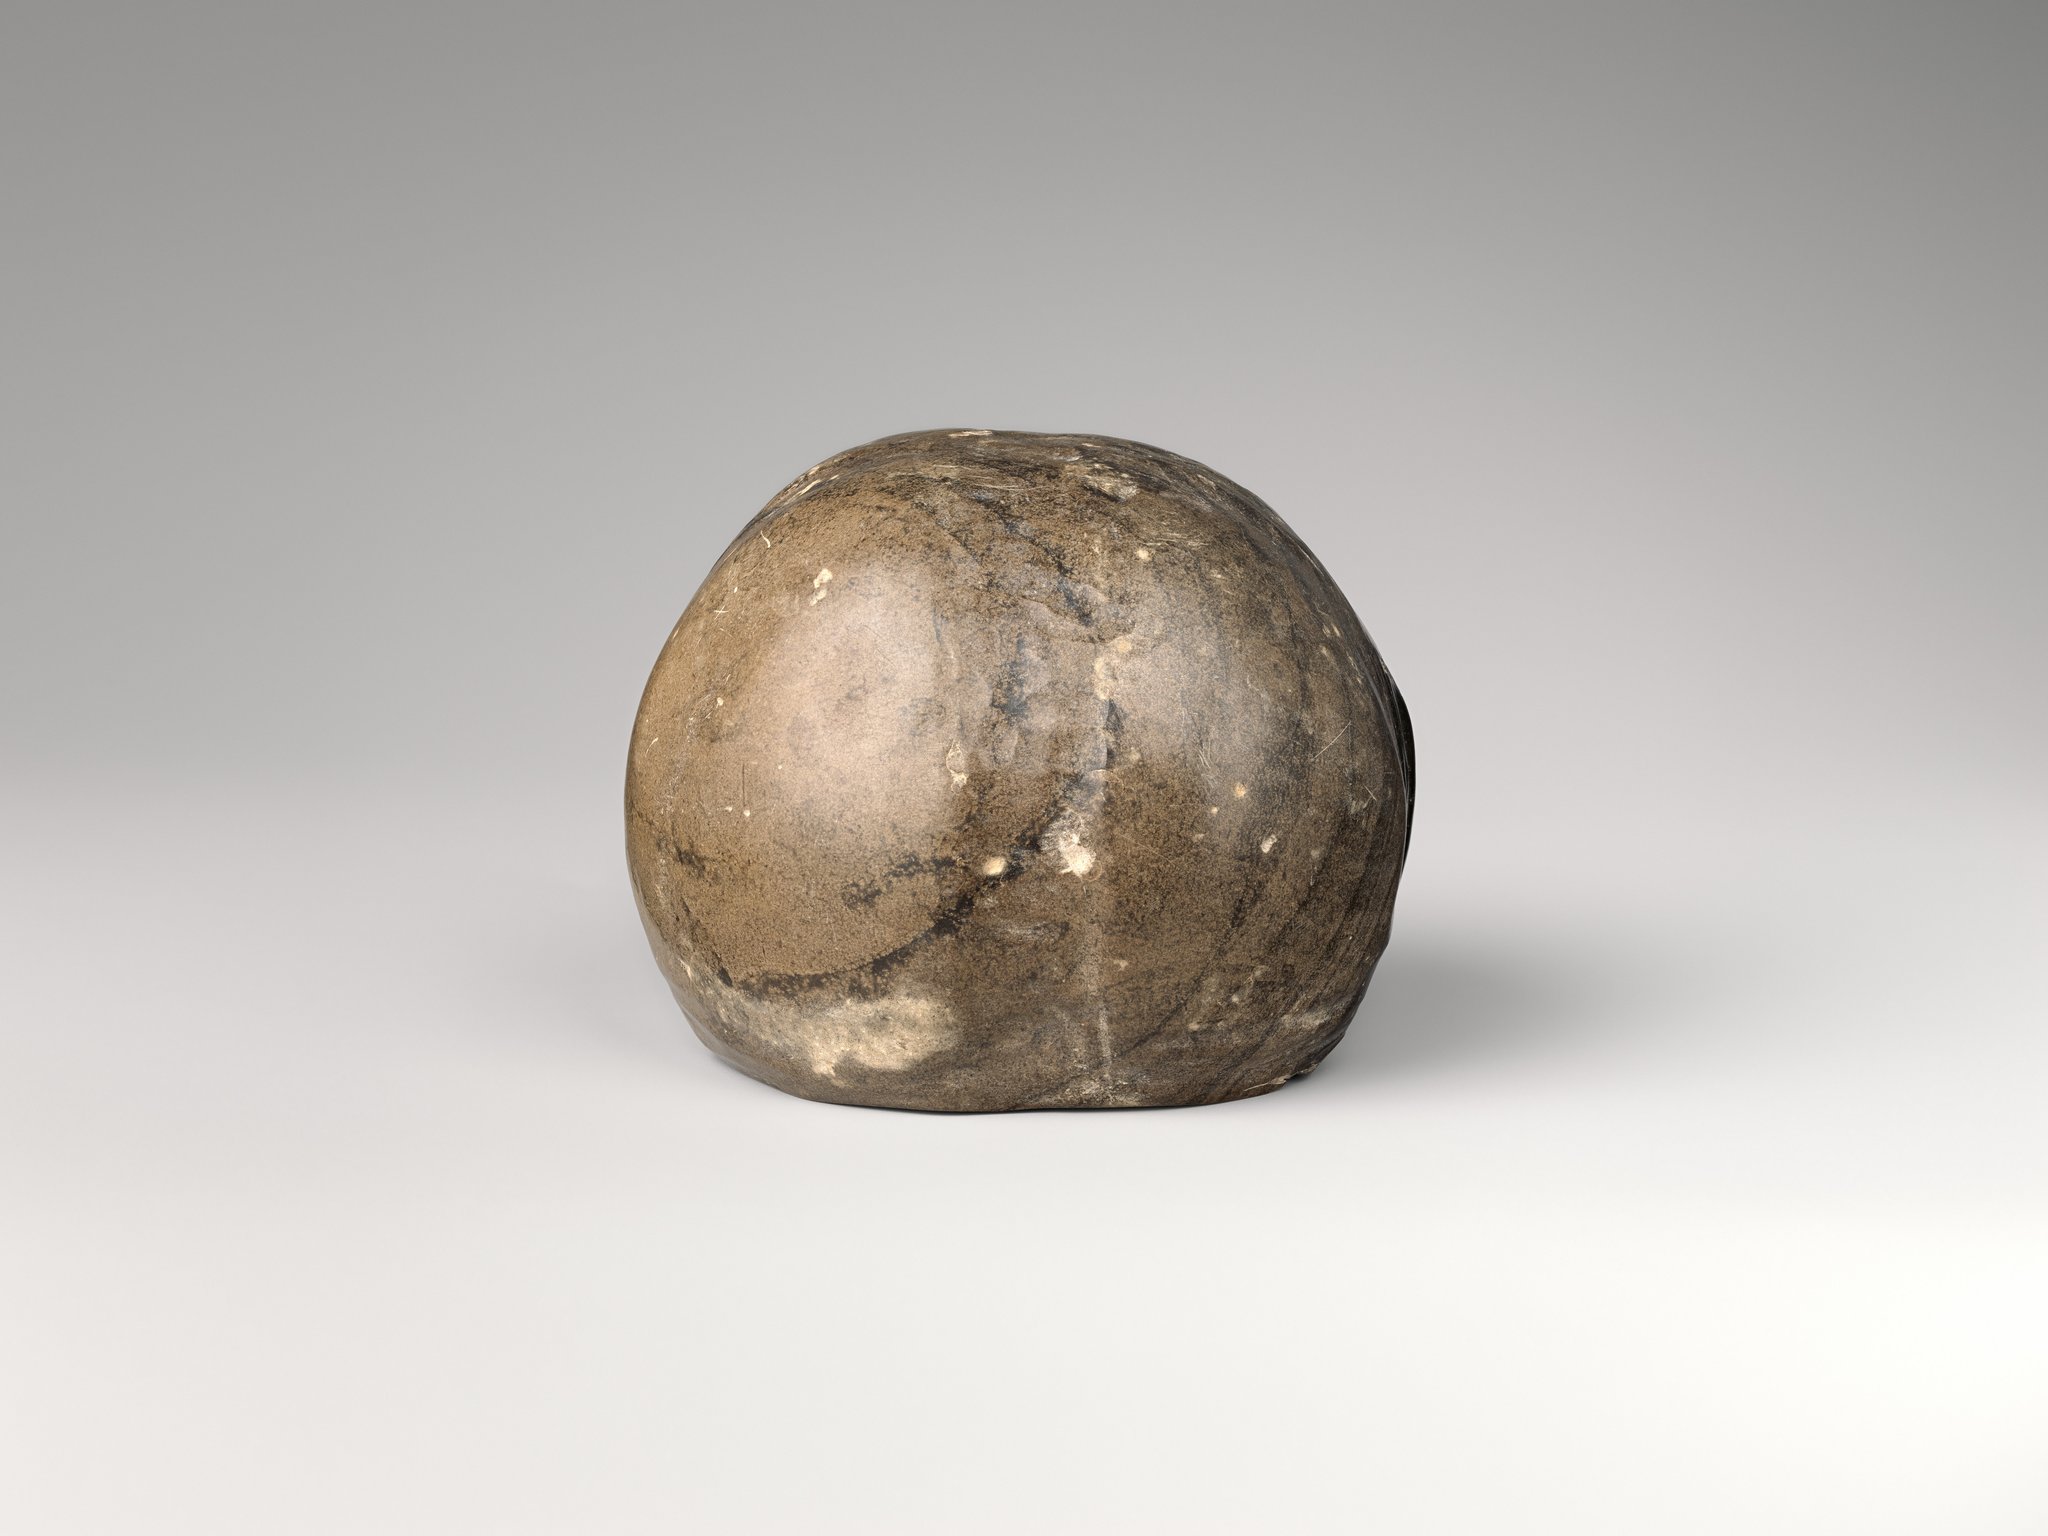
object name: object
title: Unidentified object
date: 3333-3001 BCE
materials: limestone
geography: mesopotamia